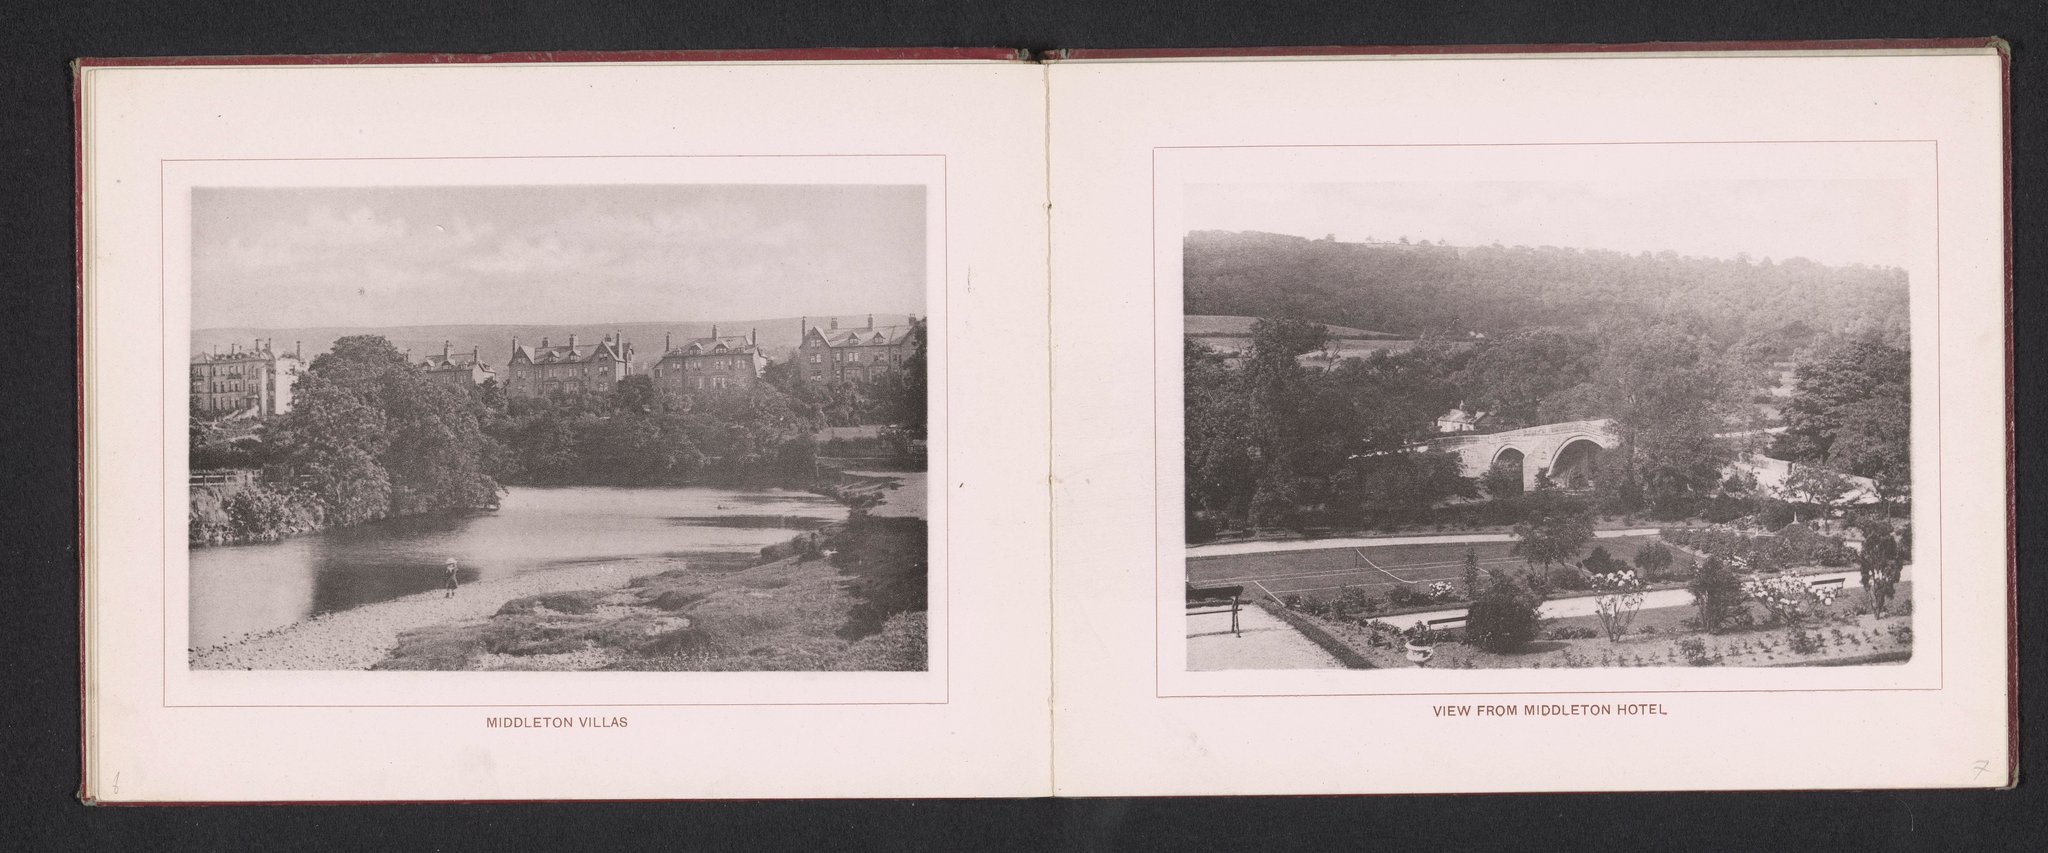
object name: page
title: Middleton villas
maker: Anonymous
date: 1890-1900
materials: paper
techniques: photograph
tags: river, villa, façade (of house or building)